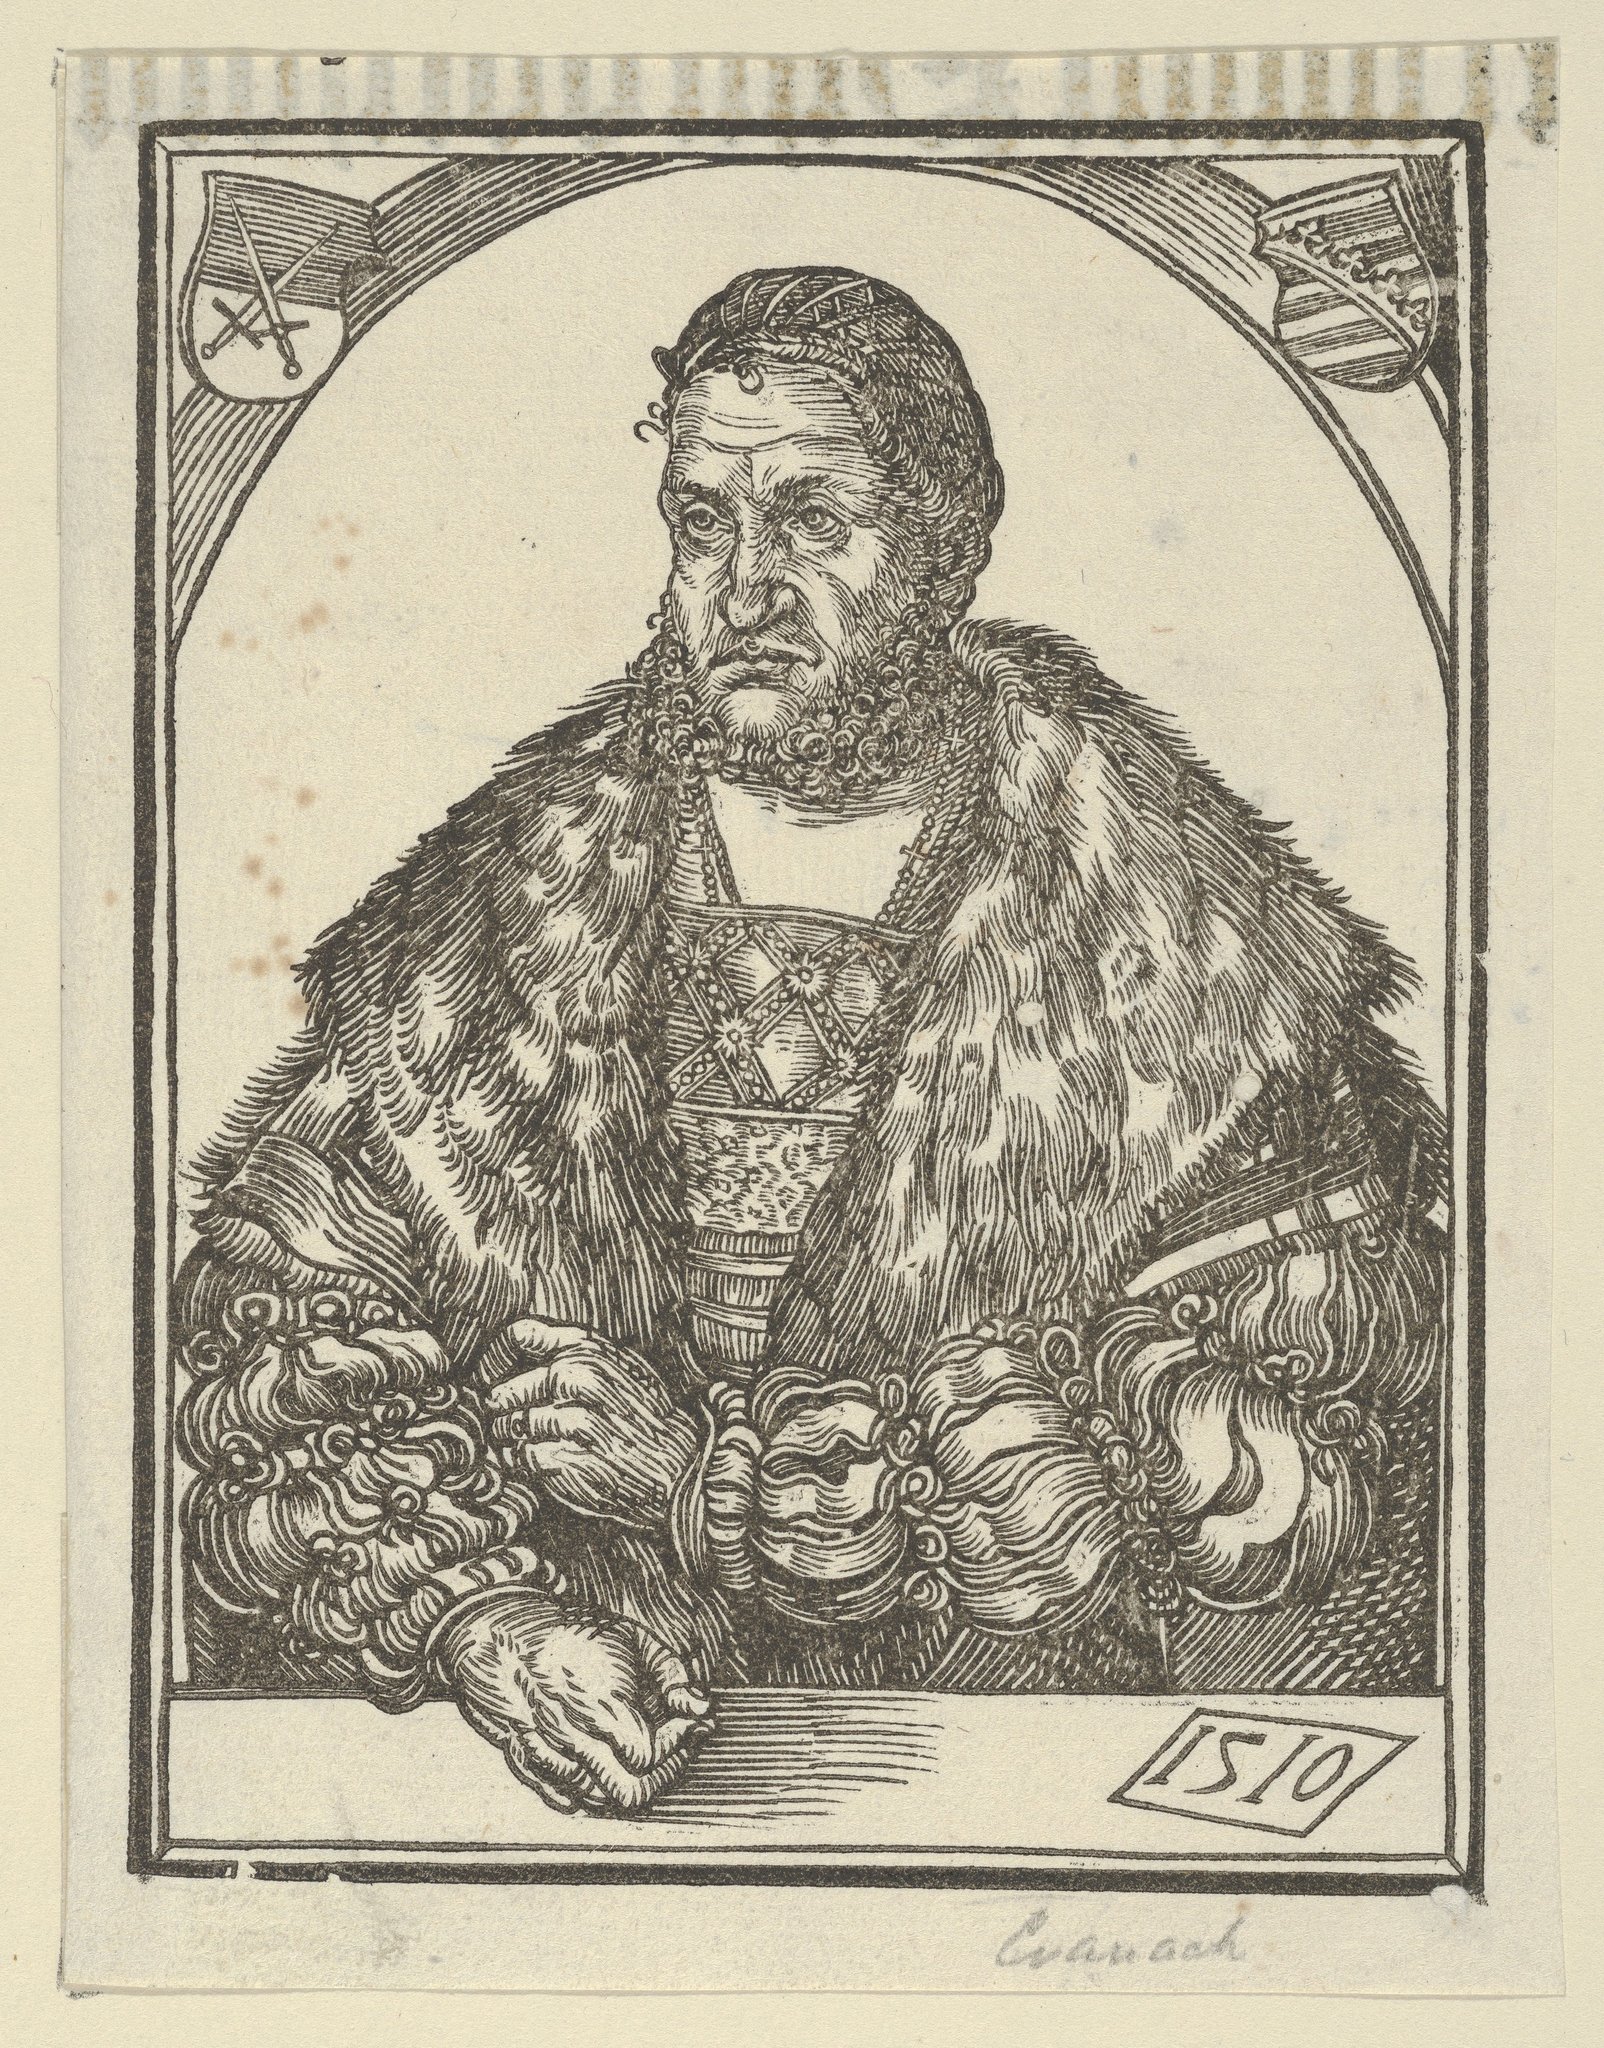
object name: print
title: Copy of Frederick the Wise of Saxony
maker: lucas cranach the elder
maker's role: artist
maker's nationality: german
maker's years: 1472-1553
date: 1509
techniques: woodcut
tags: men,portraits